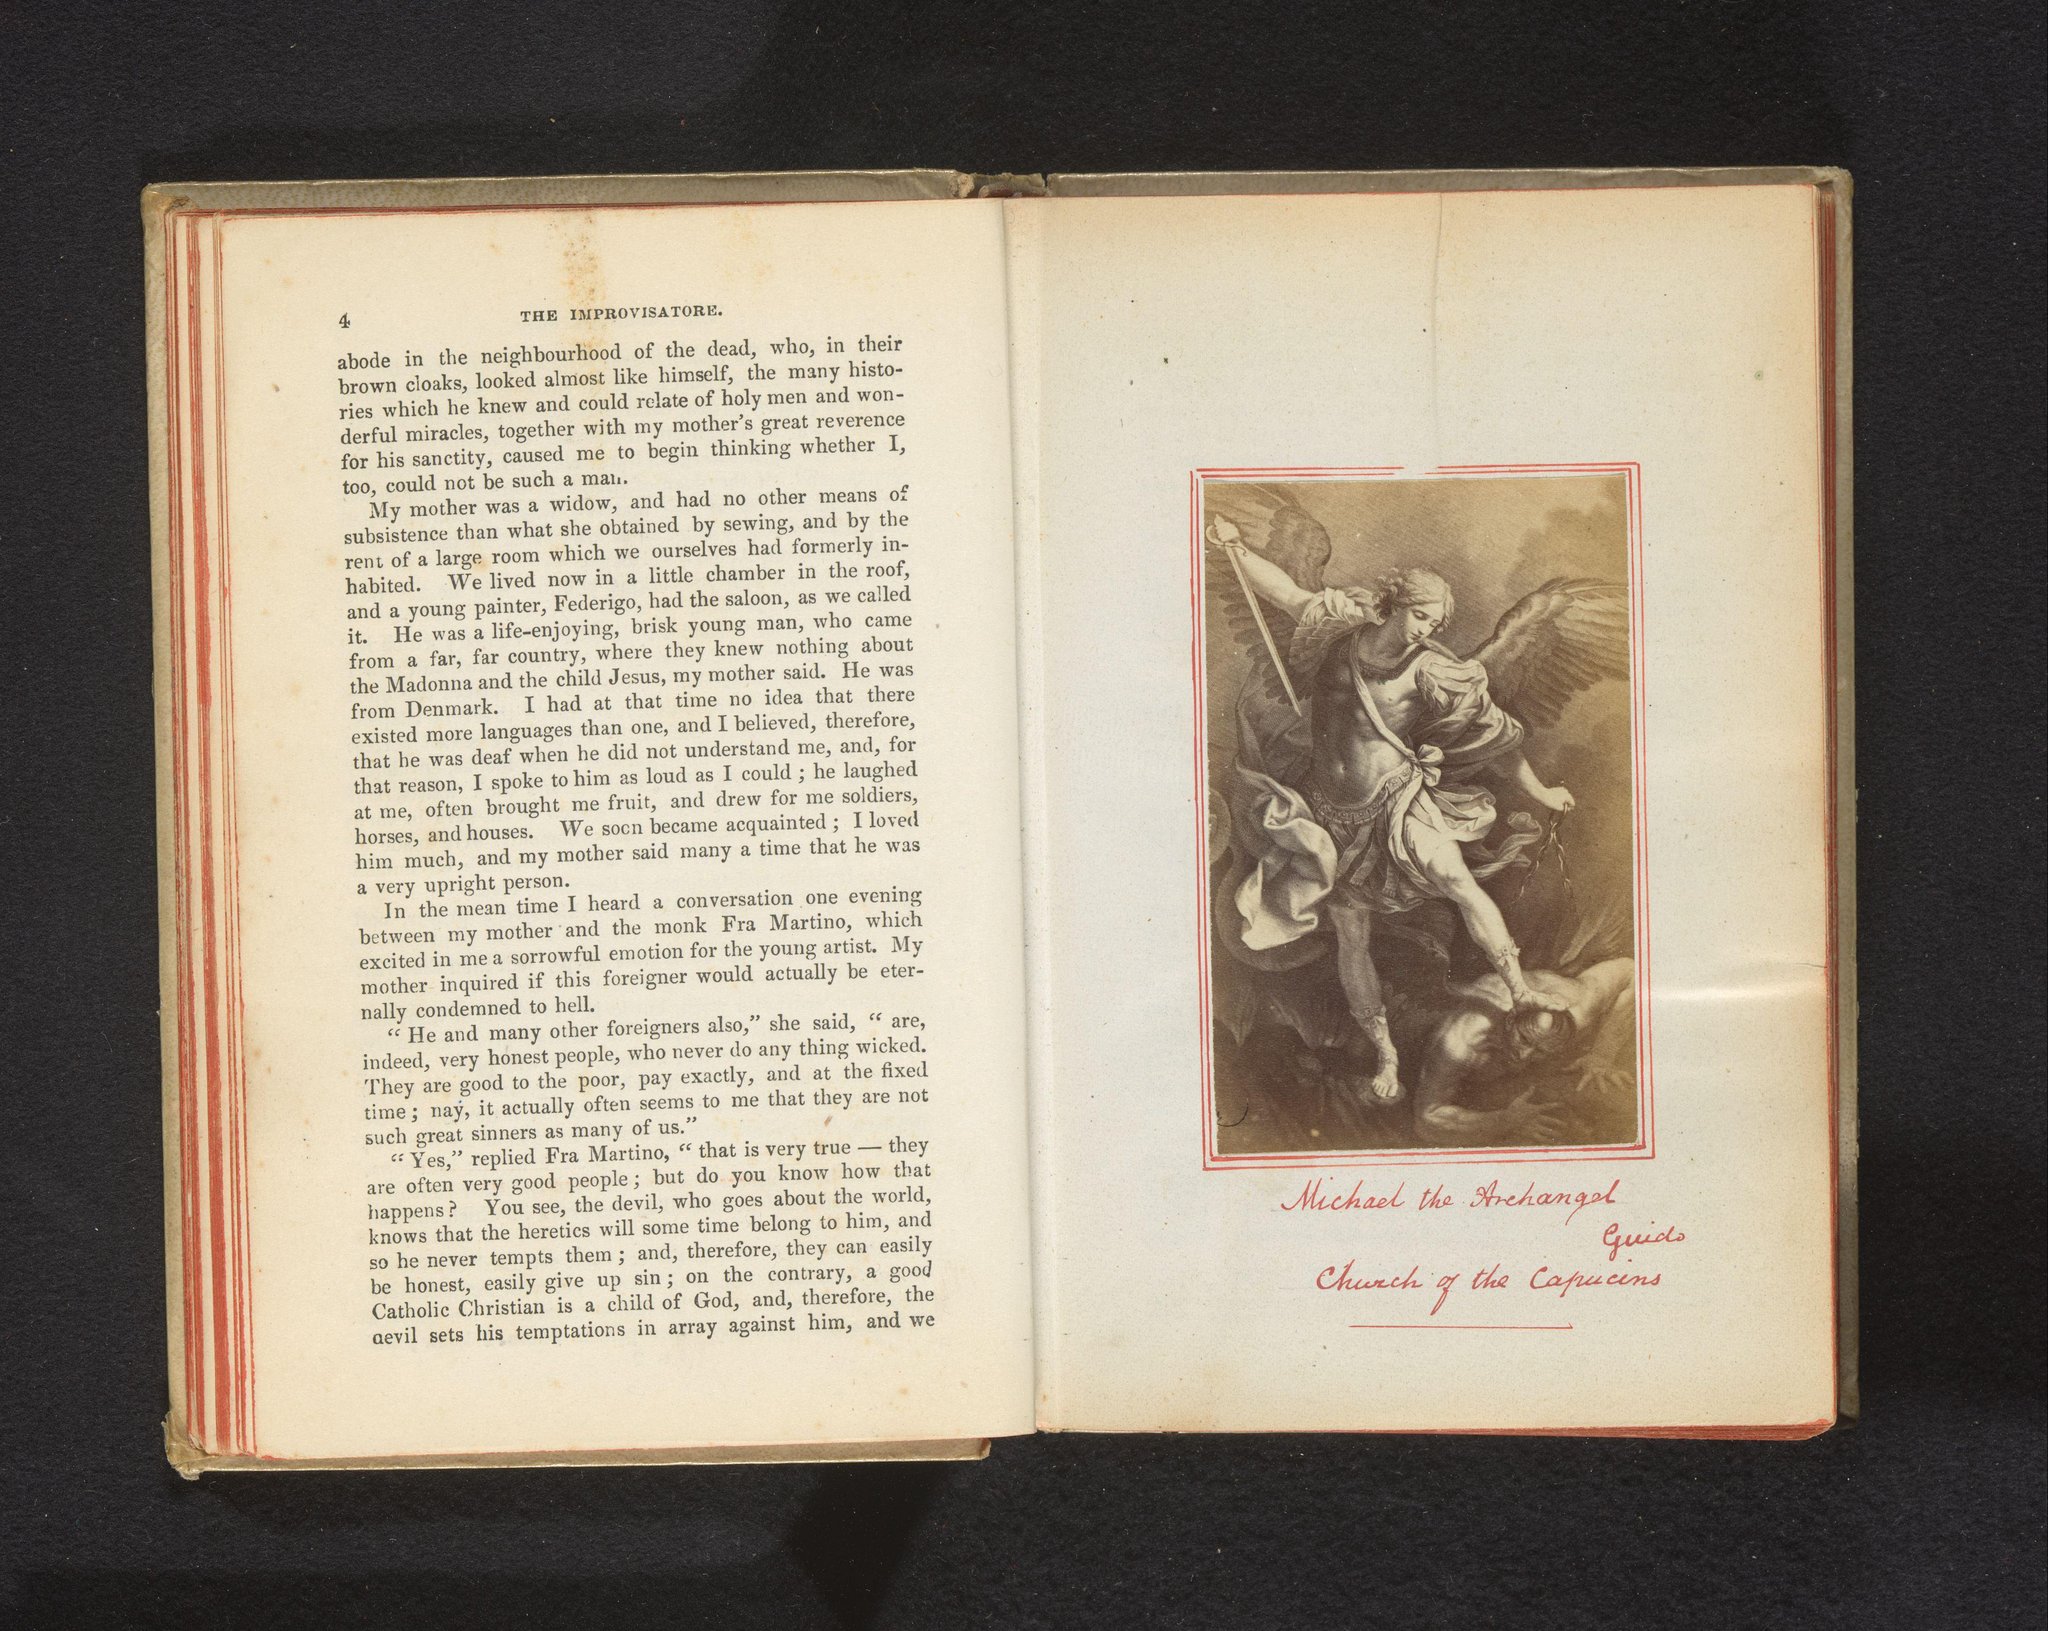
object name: reproduction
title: Michael the Archangel Guido Church of the Capucins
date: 1863-1873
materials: photographic support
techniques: albumen print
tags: the archangel michael fighting the dragon (devil, satan)